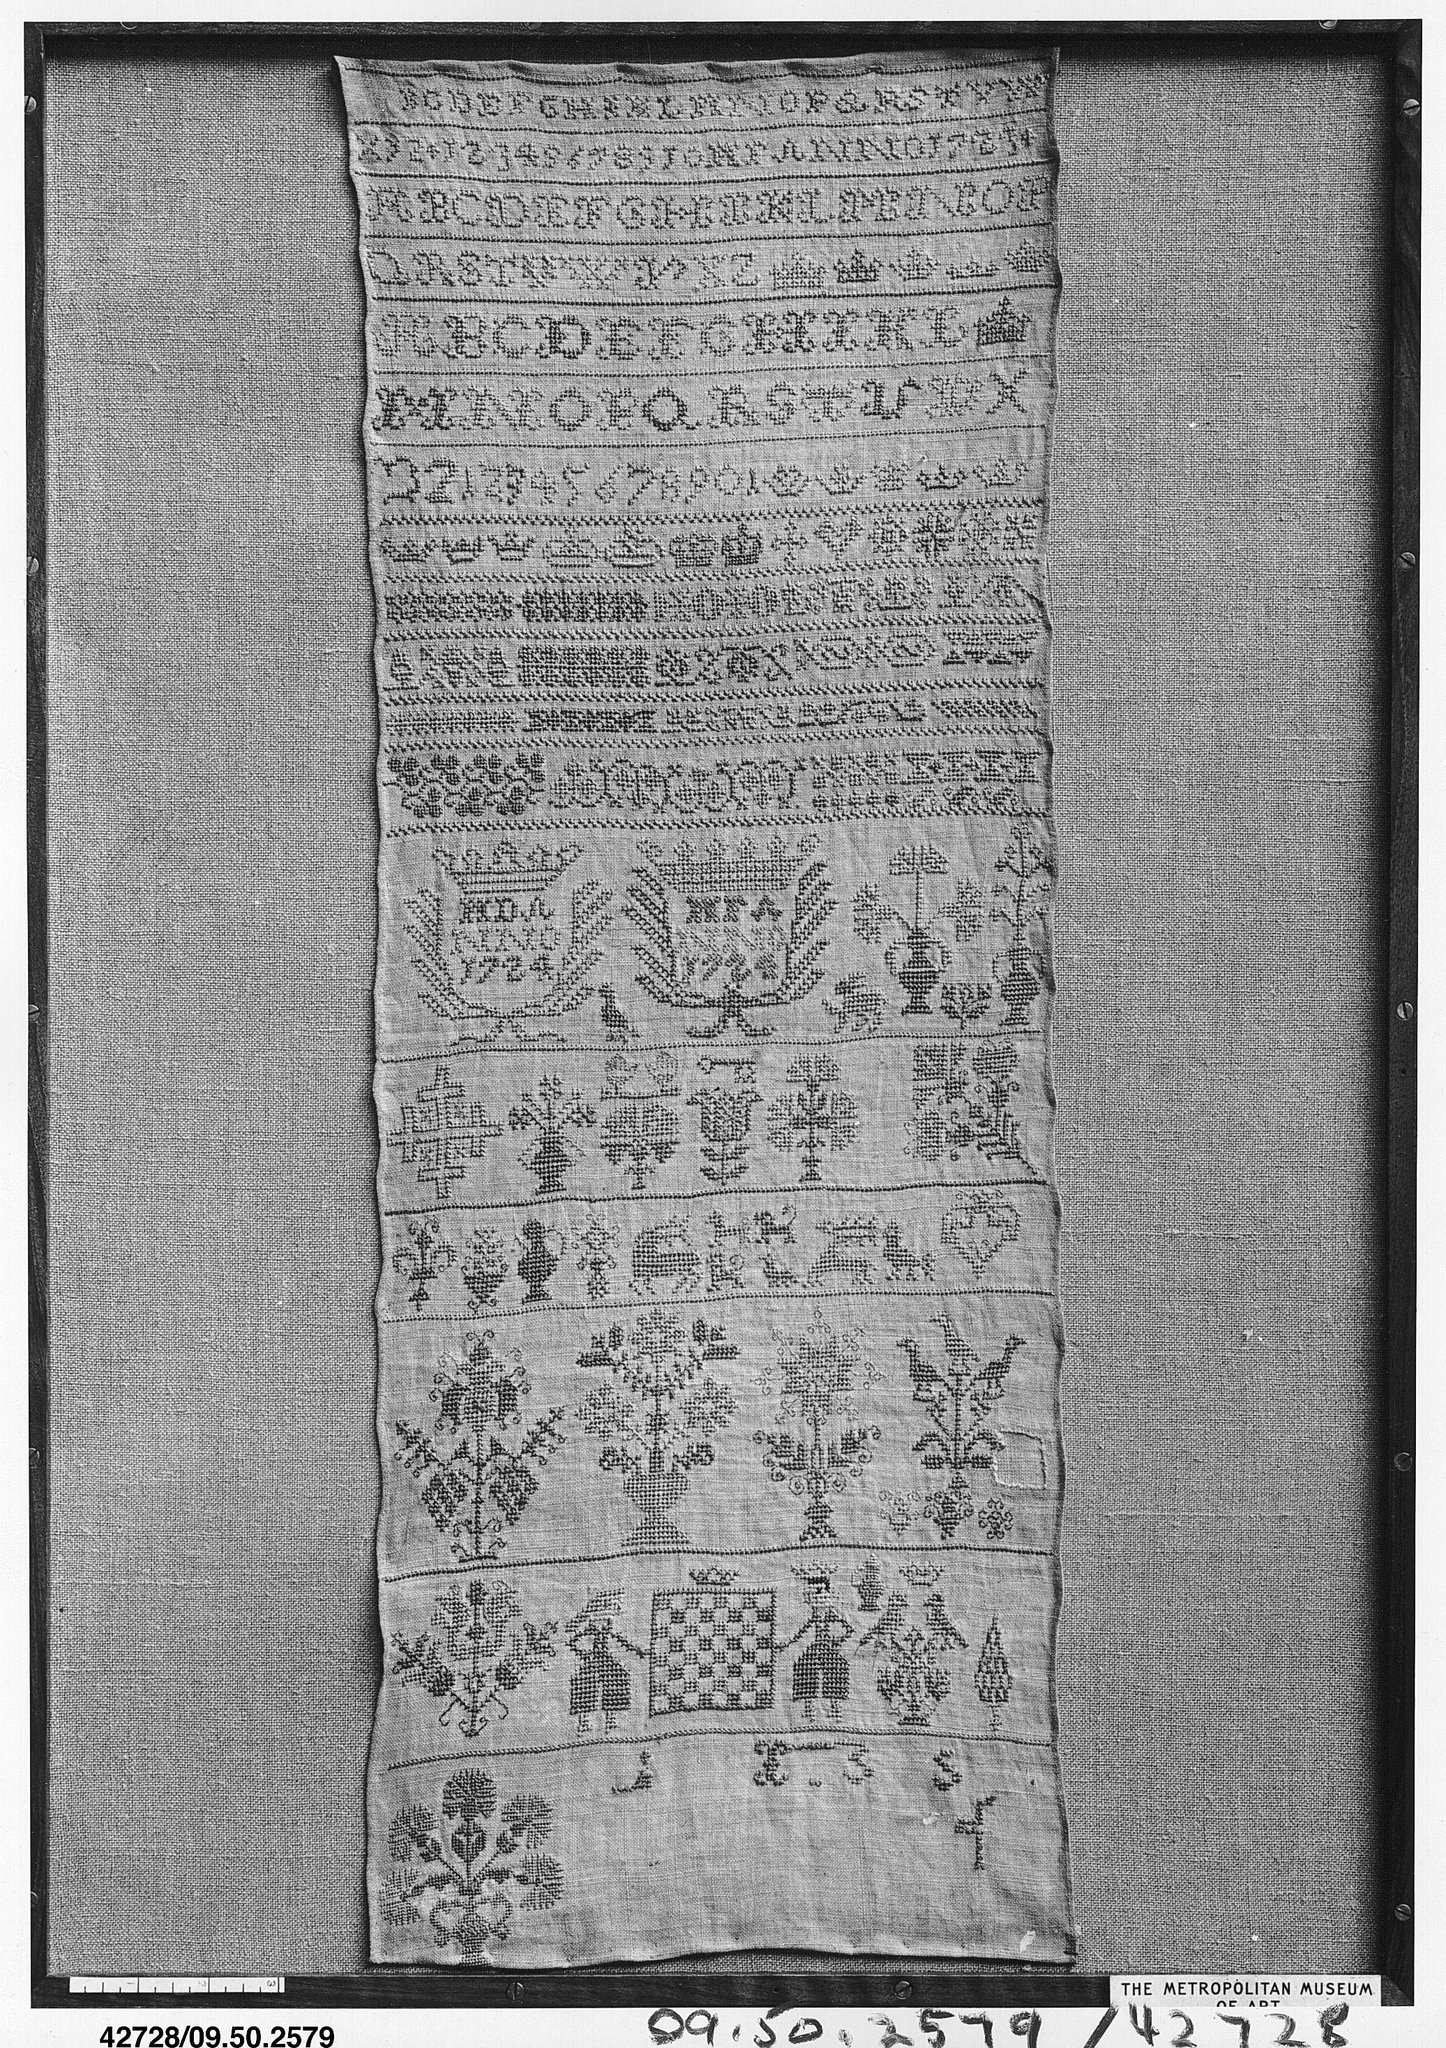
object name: sampler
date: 1724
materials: linen, silk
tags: birds,men,women,flowers